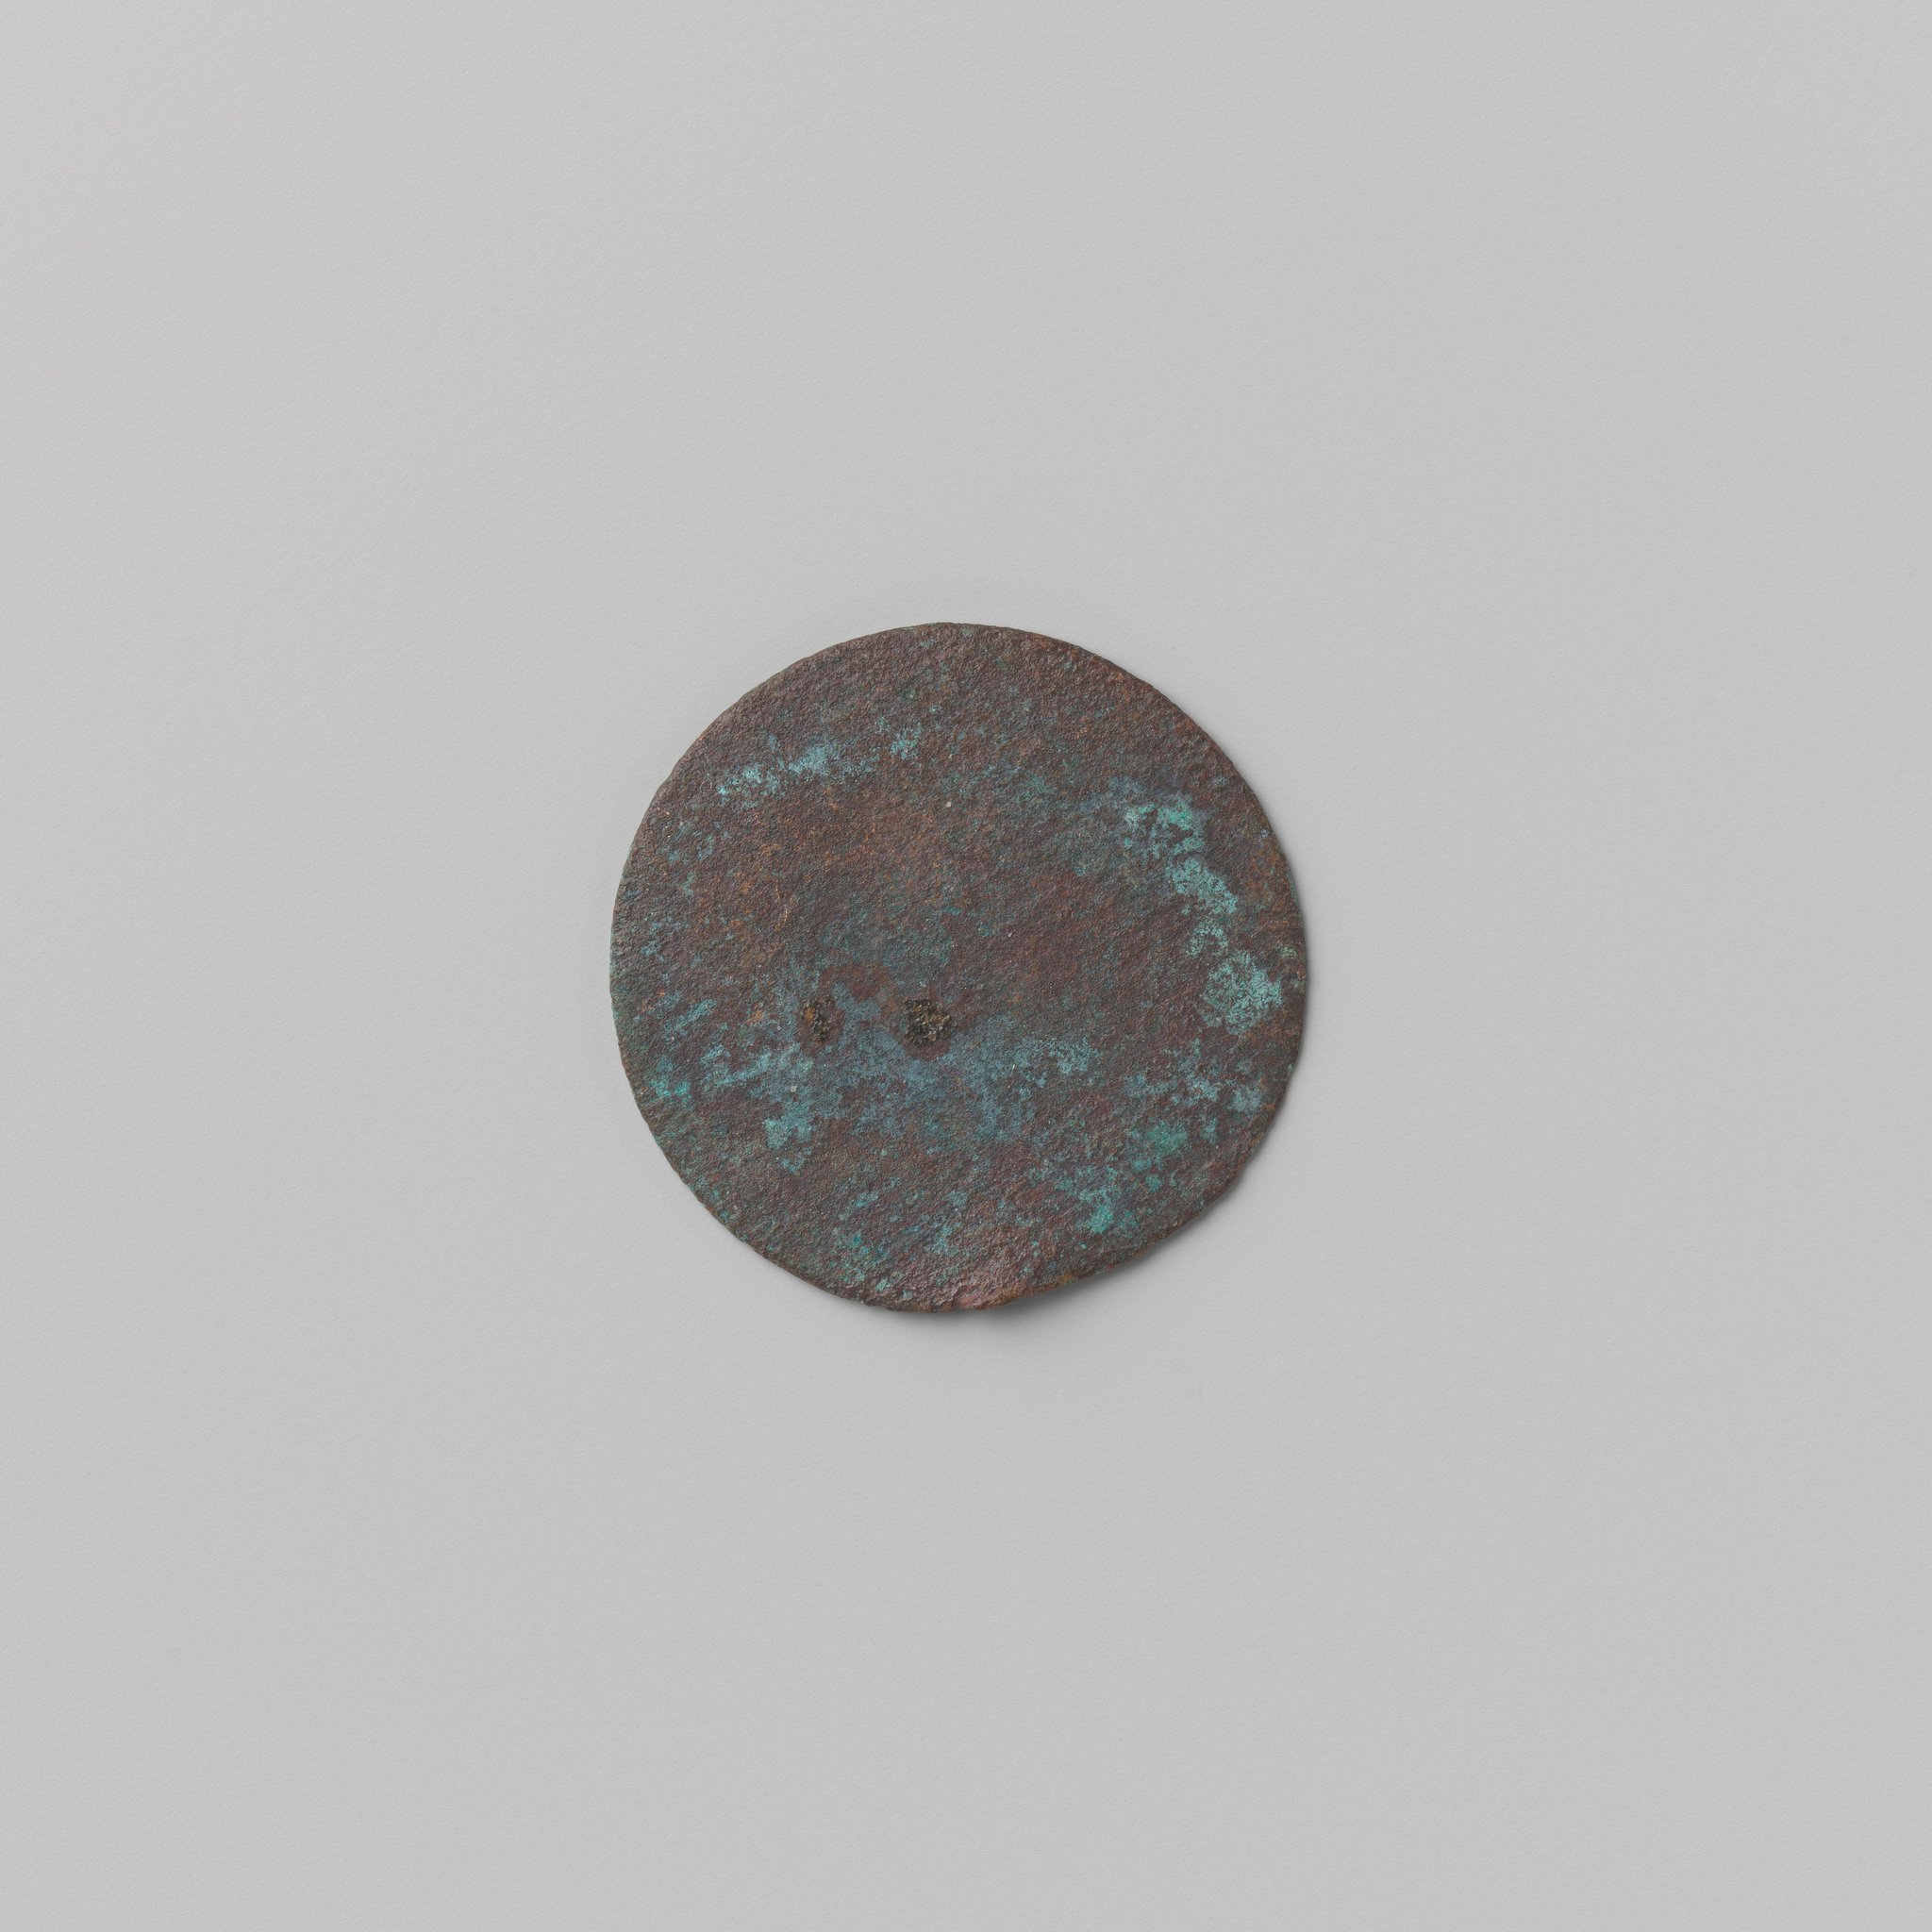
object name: vijf real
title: Rondel (ongeslagen muntplaatje)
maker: Anonymous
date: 1700-1800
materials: copper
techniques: striking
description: Rondel, gevonden op het strand van Terschelling, waarschijnlijk van Zweedse oorsprong en in Göteborg of Hamburg ingeladen in een schip dat – op weg naar Lissabon – nabij Terschelling zonk.